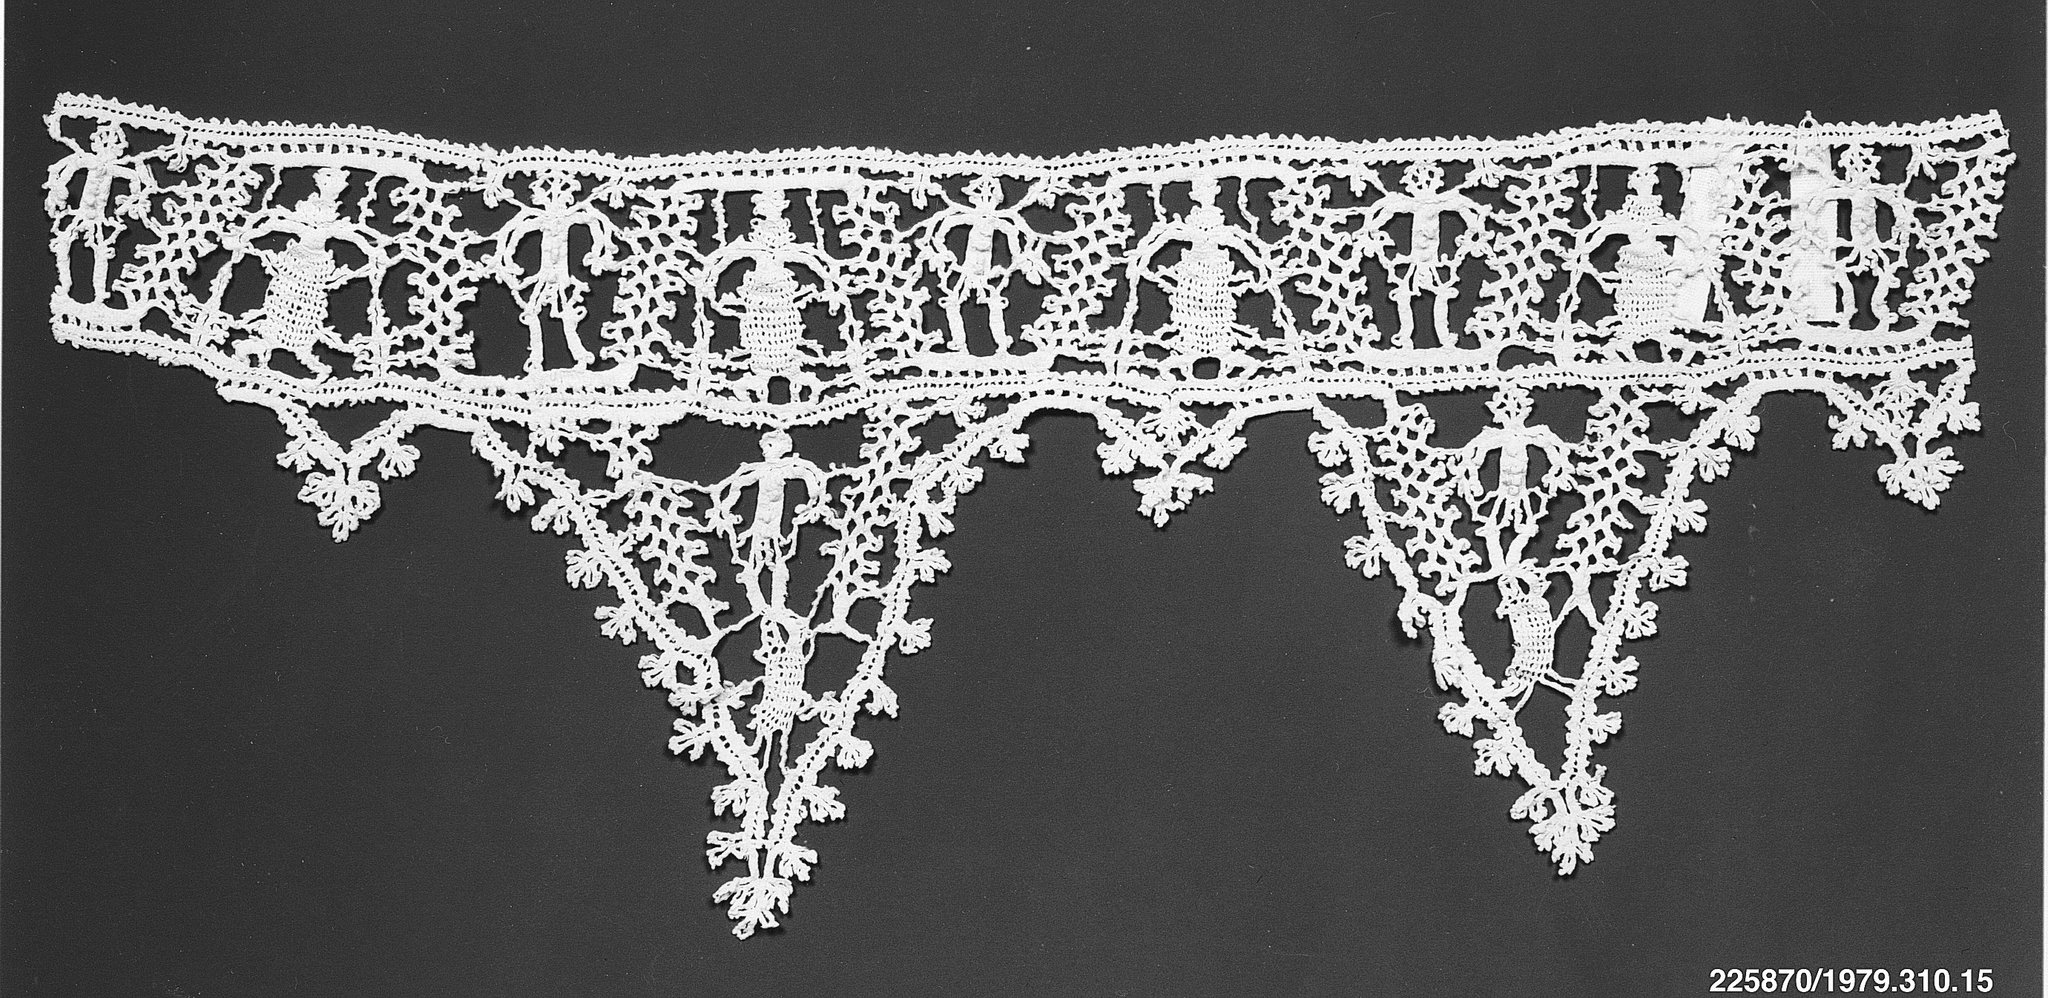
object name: edging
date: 1567-1600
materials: linen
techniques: lace